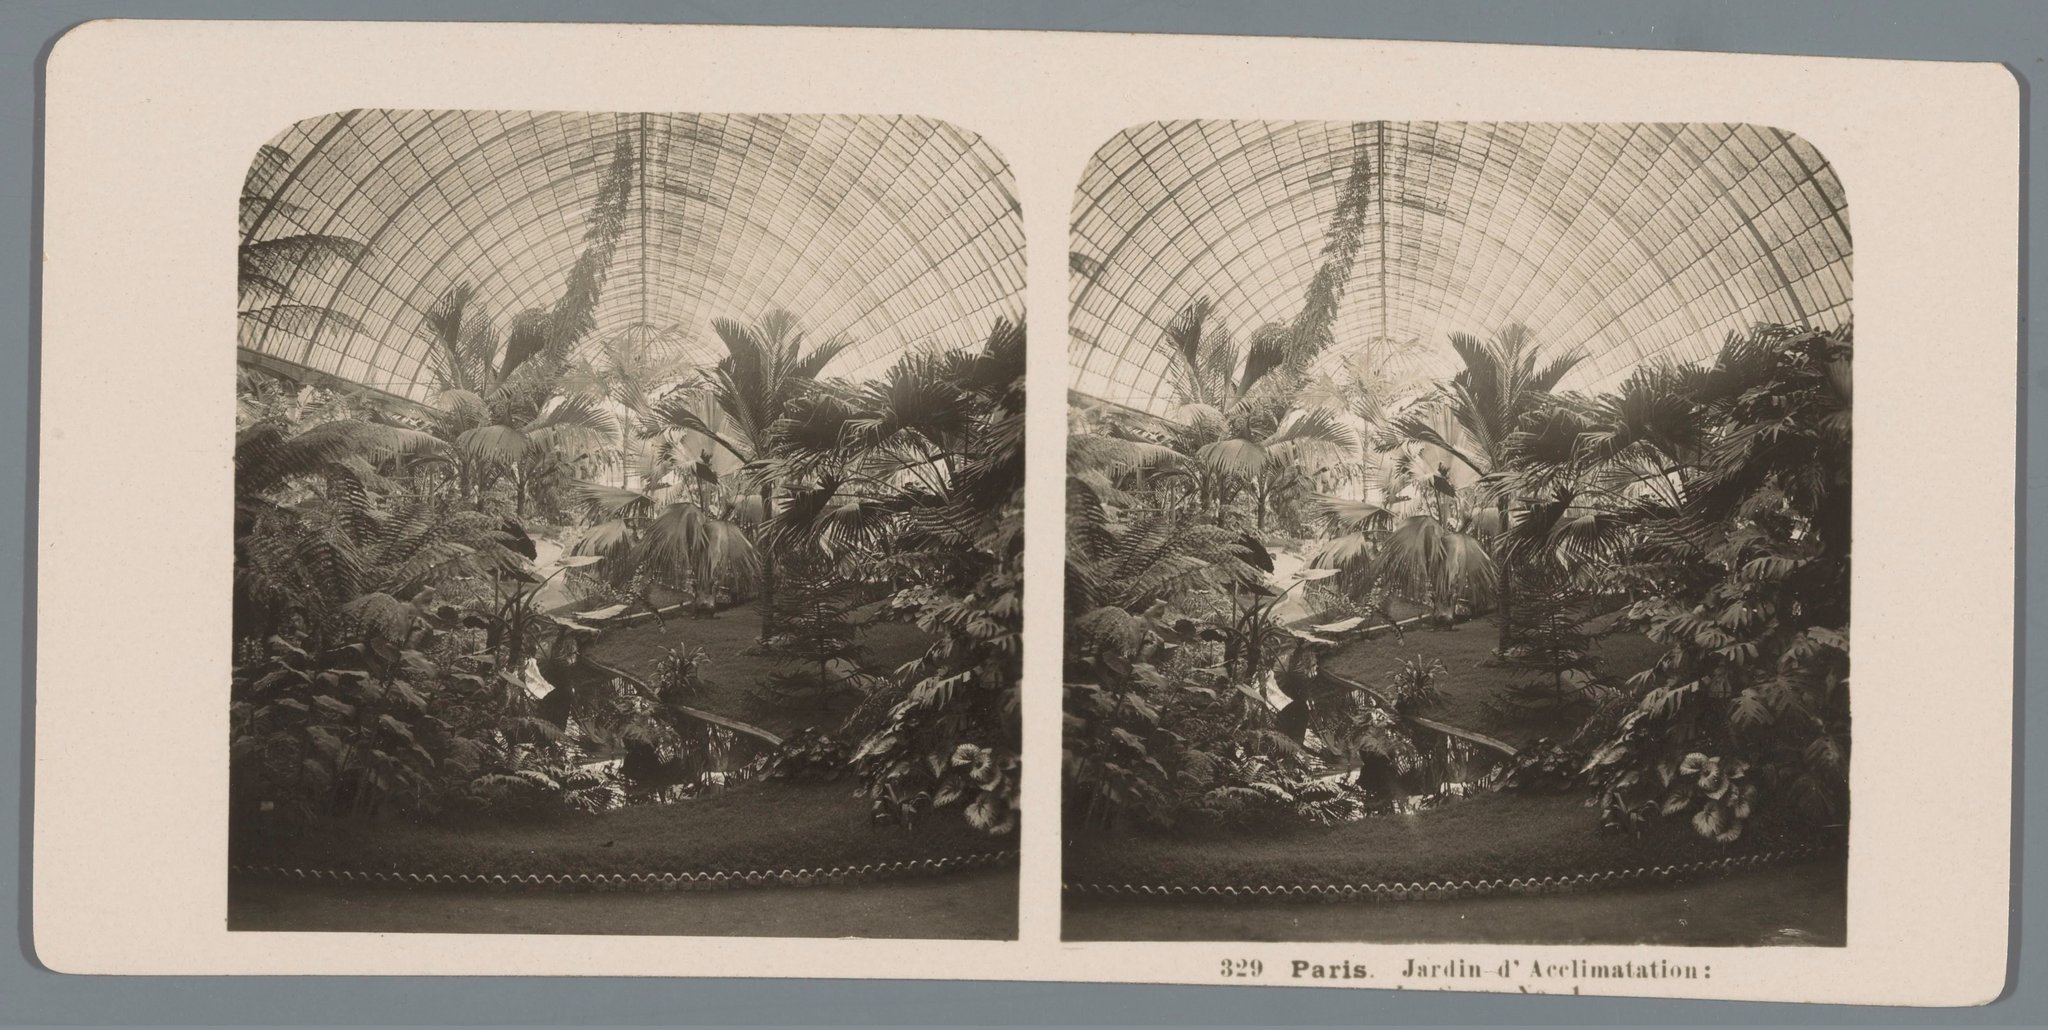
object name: stereograph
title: Paris. Jardin d'acclimatation: [(...)]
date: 1903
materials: cardboard, photographic support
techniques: gelatin silver print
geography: jardin d'acclimatation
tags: botanic garden, 'hortus botanicus', greenhouse, orangery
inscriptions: inscription: ‘Neue Photographische Gesellschaft A.-G. Steglitz-Berlin 1903.’, number: ‘329’